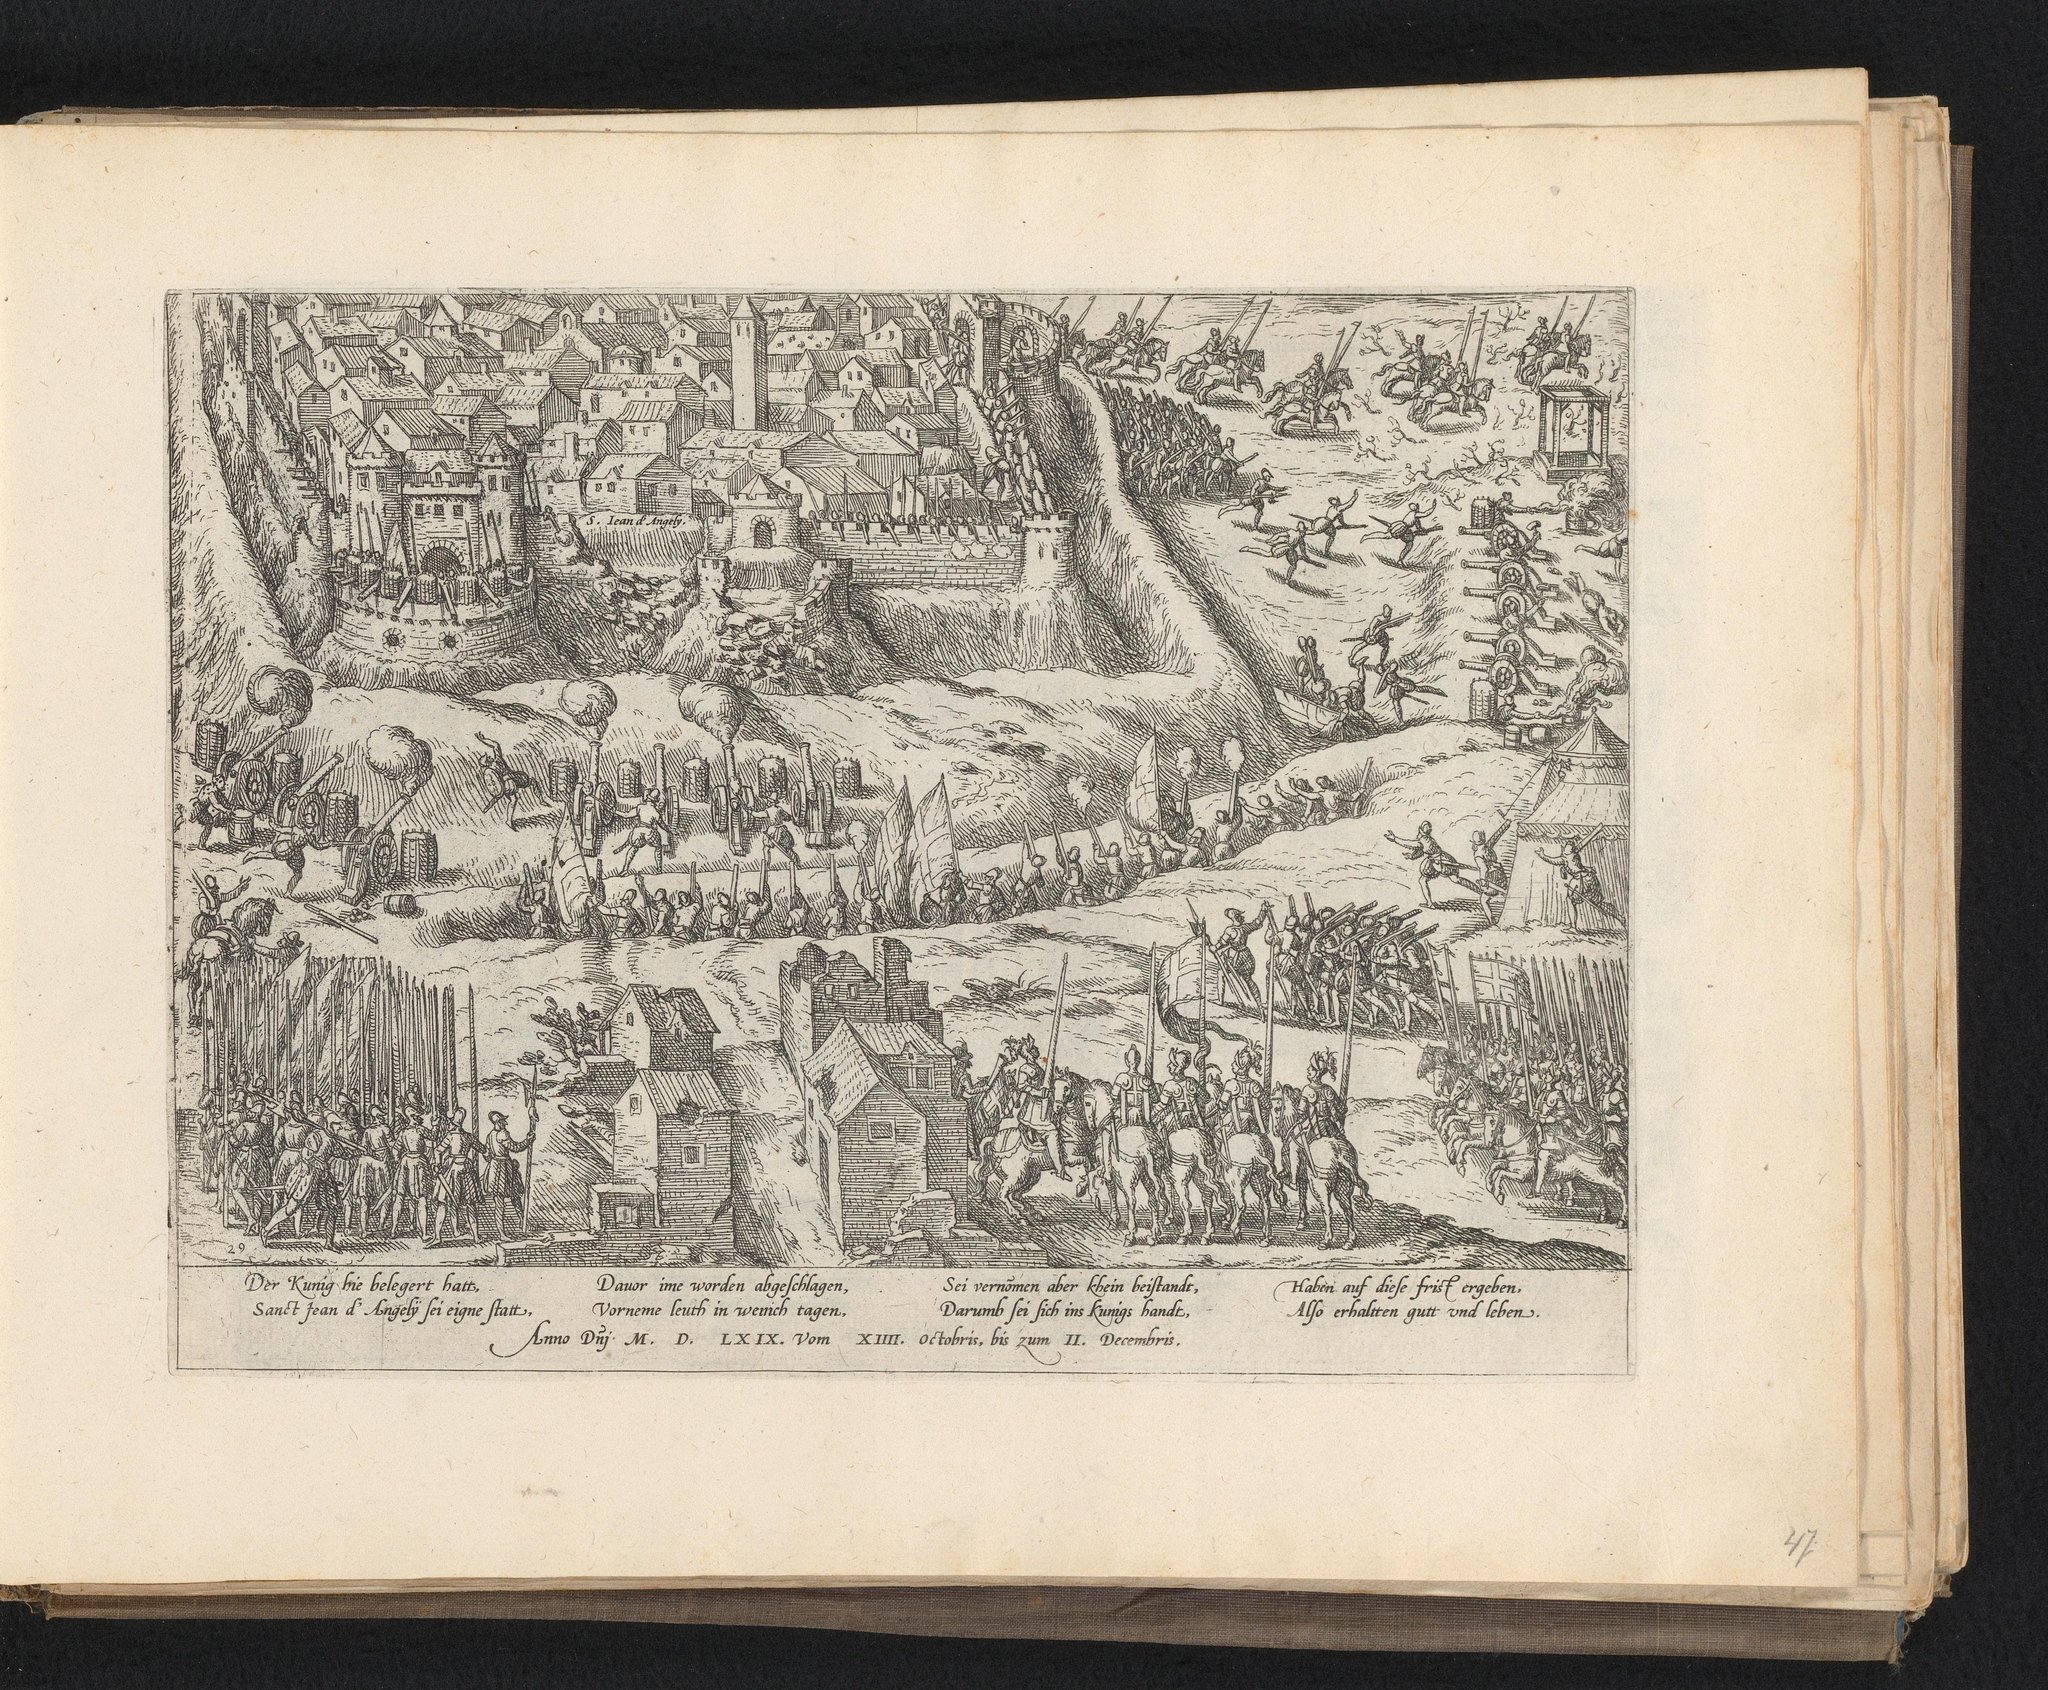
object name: album leaf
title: Beleg van Saint-Jean d'Angély onder leiding van Karel IX, koning van Frankrijk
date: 1569-1573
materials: paper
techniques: etching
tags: karel ix (koning van frankrijk), siege, position war, militant proselytizing: religious war, crusade, etc., the roman catholic church vs. protestantism; (reformation and counter reformation)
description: Prent gebruikt in: Aitsinger, Michael. De Leone Belgico (...). Keulen: s.n., 1588.